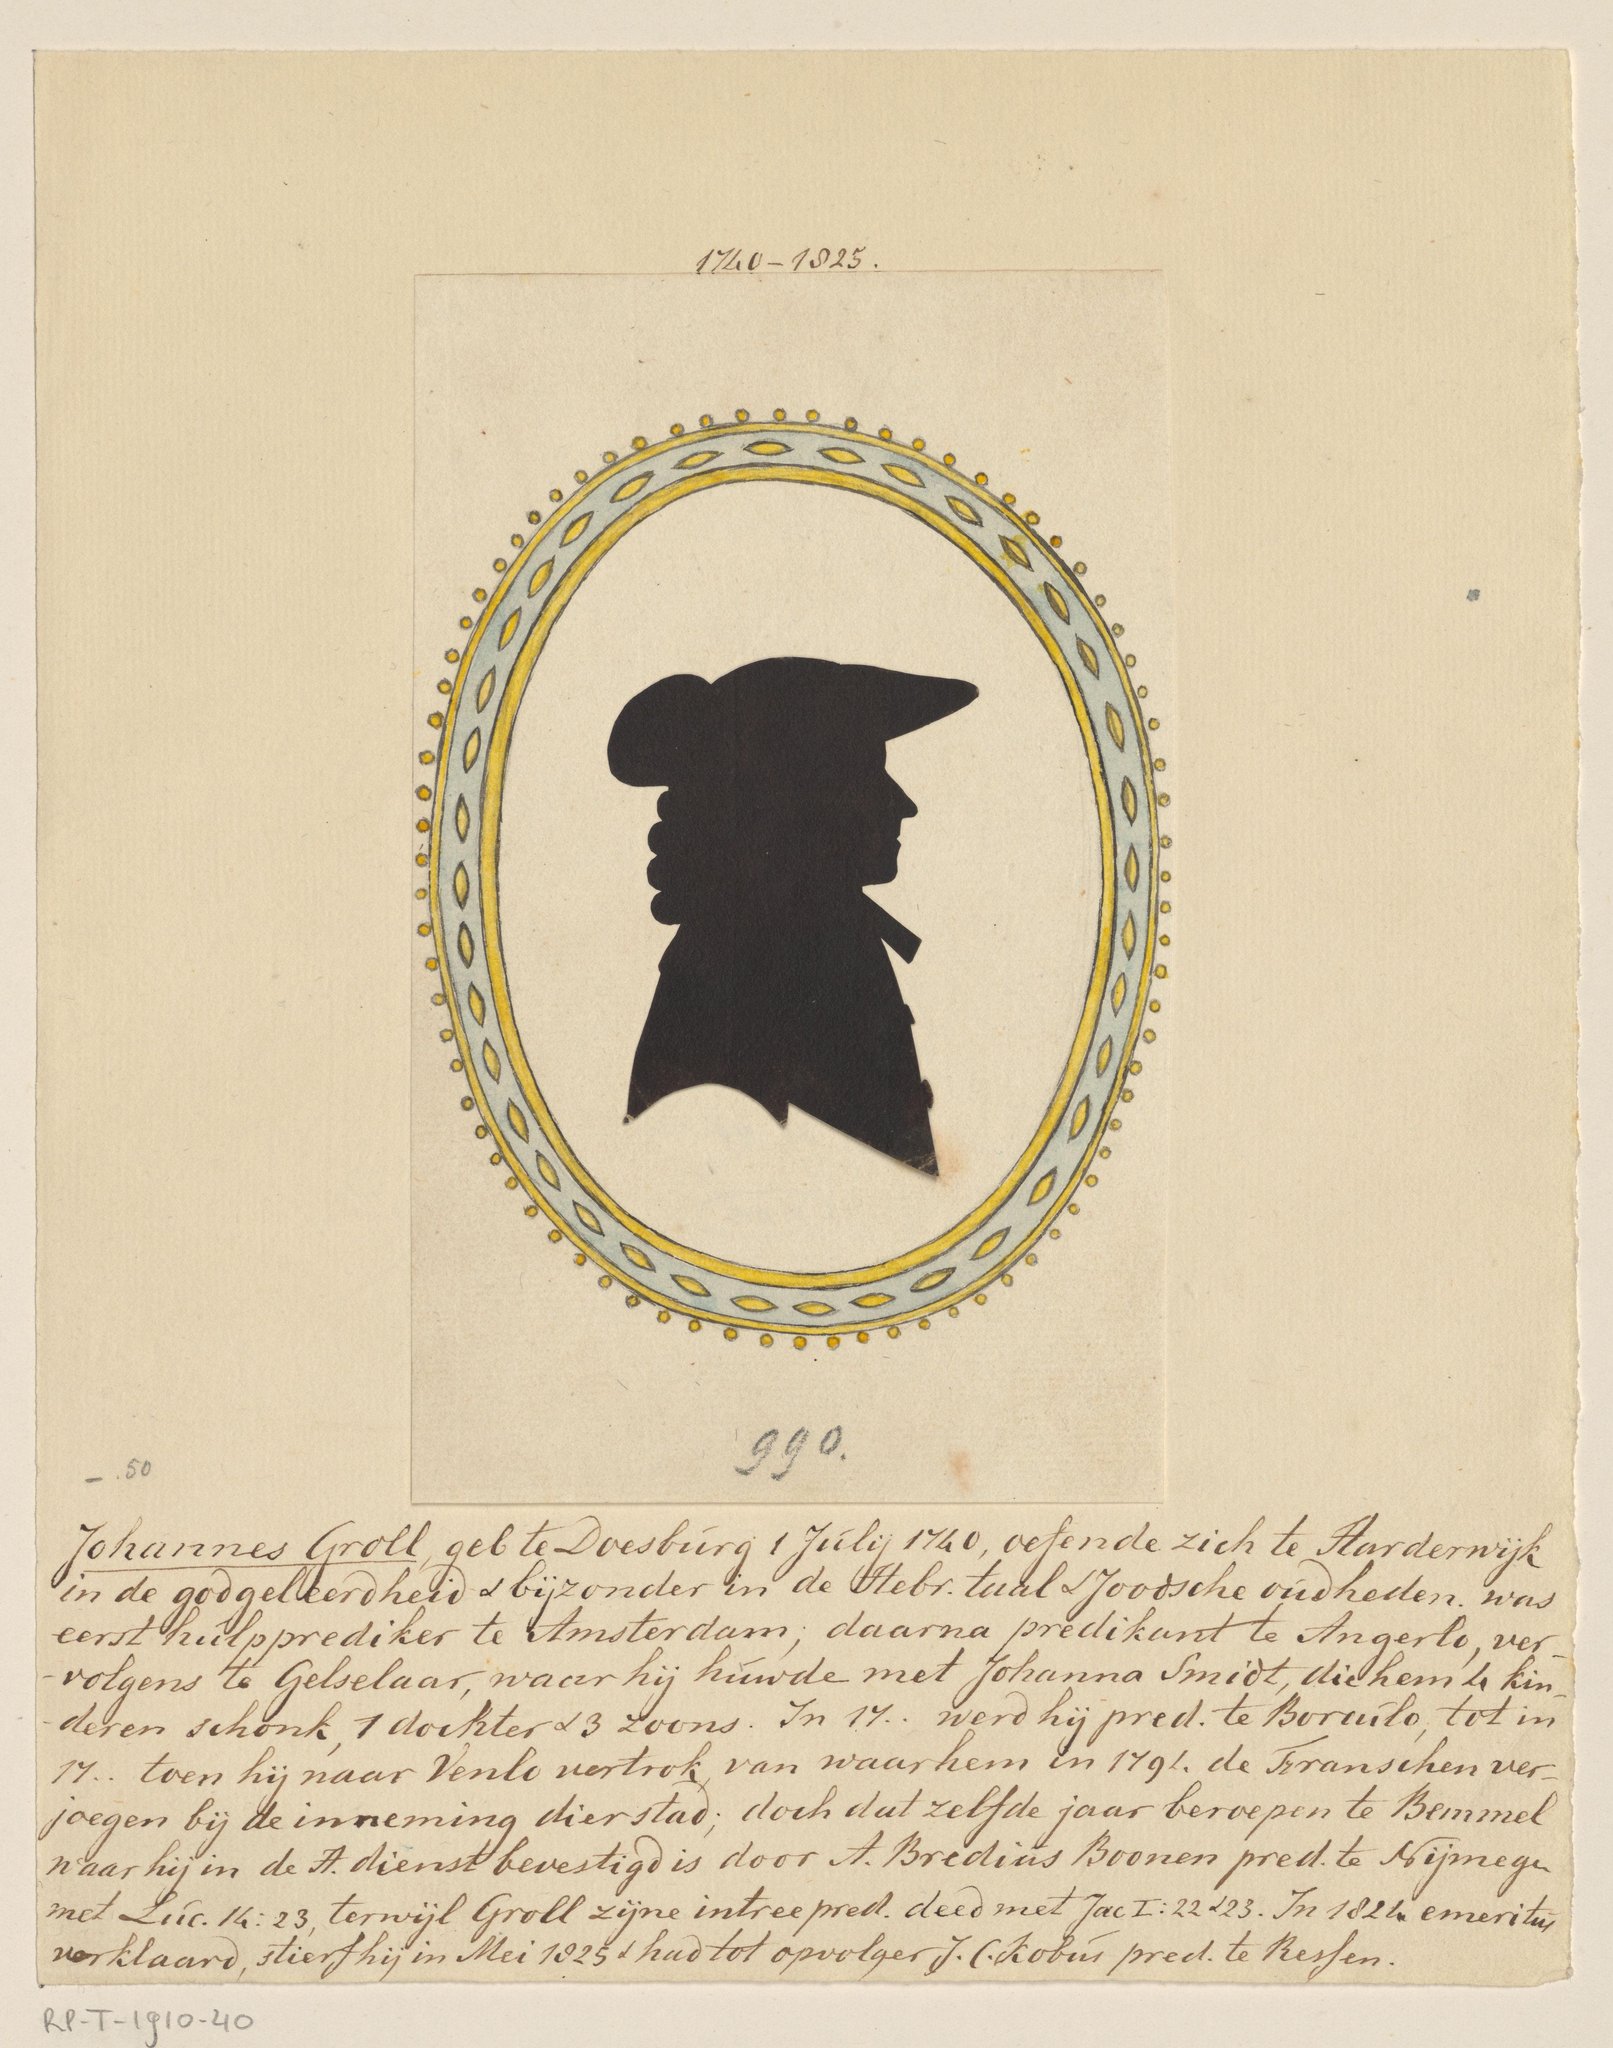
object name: cut paper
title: Silhouetportret van Johann Groll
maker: Anonymous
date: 1800-1900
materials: ink, paint, paper, pencil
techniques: brush, snipping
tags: abcoude, leiden, theologian, historical persons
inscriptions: collector's mark: Lugt 2228, : ‘v. S. II, no 2132’